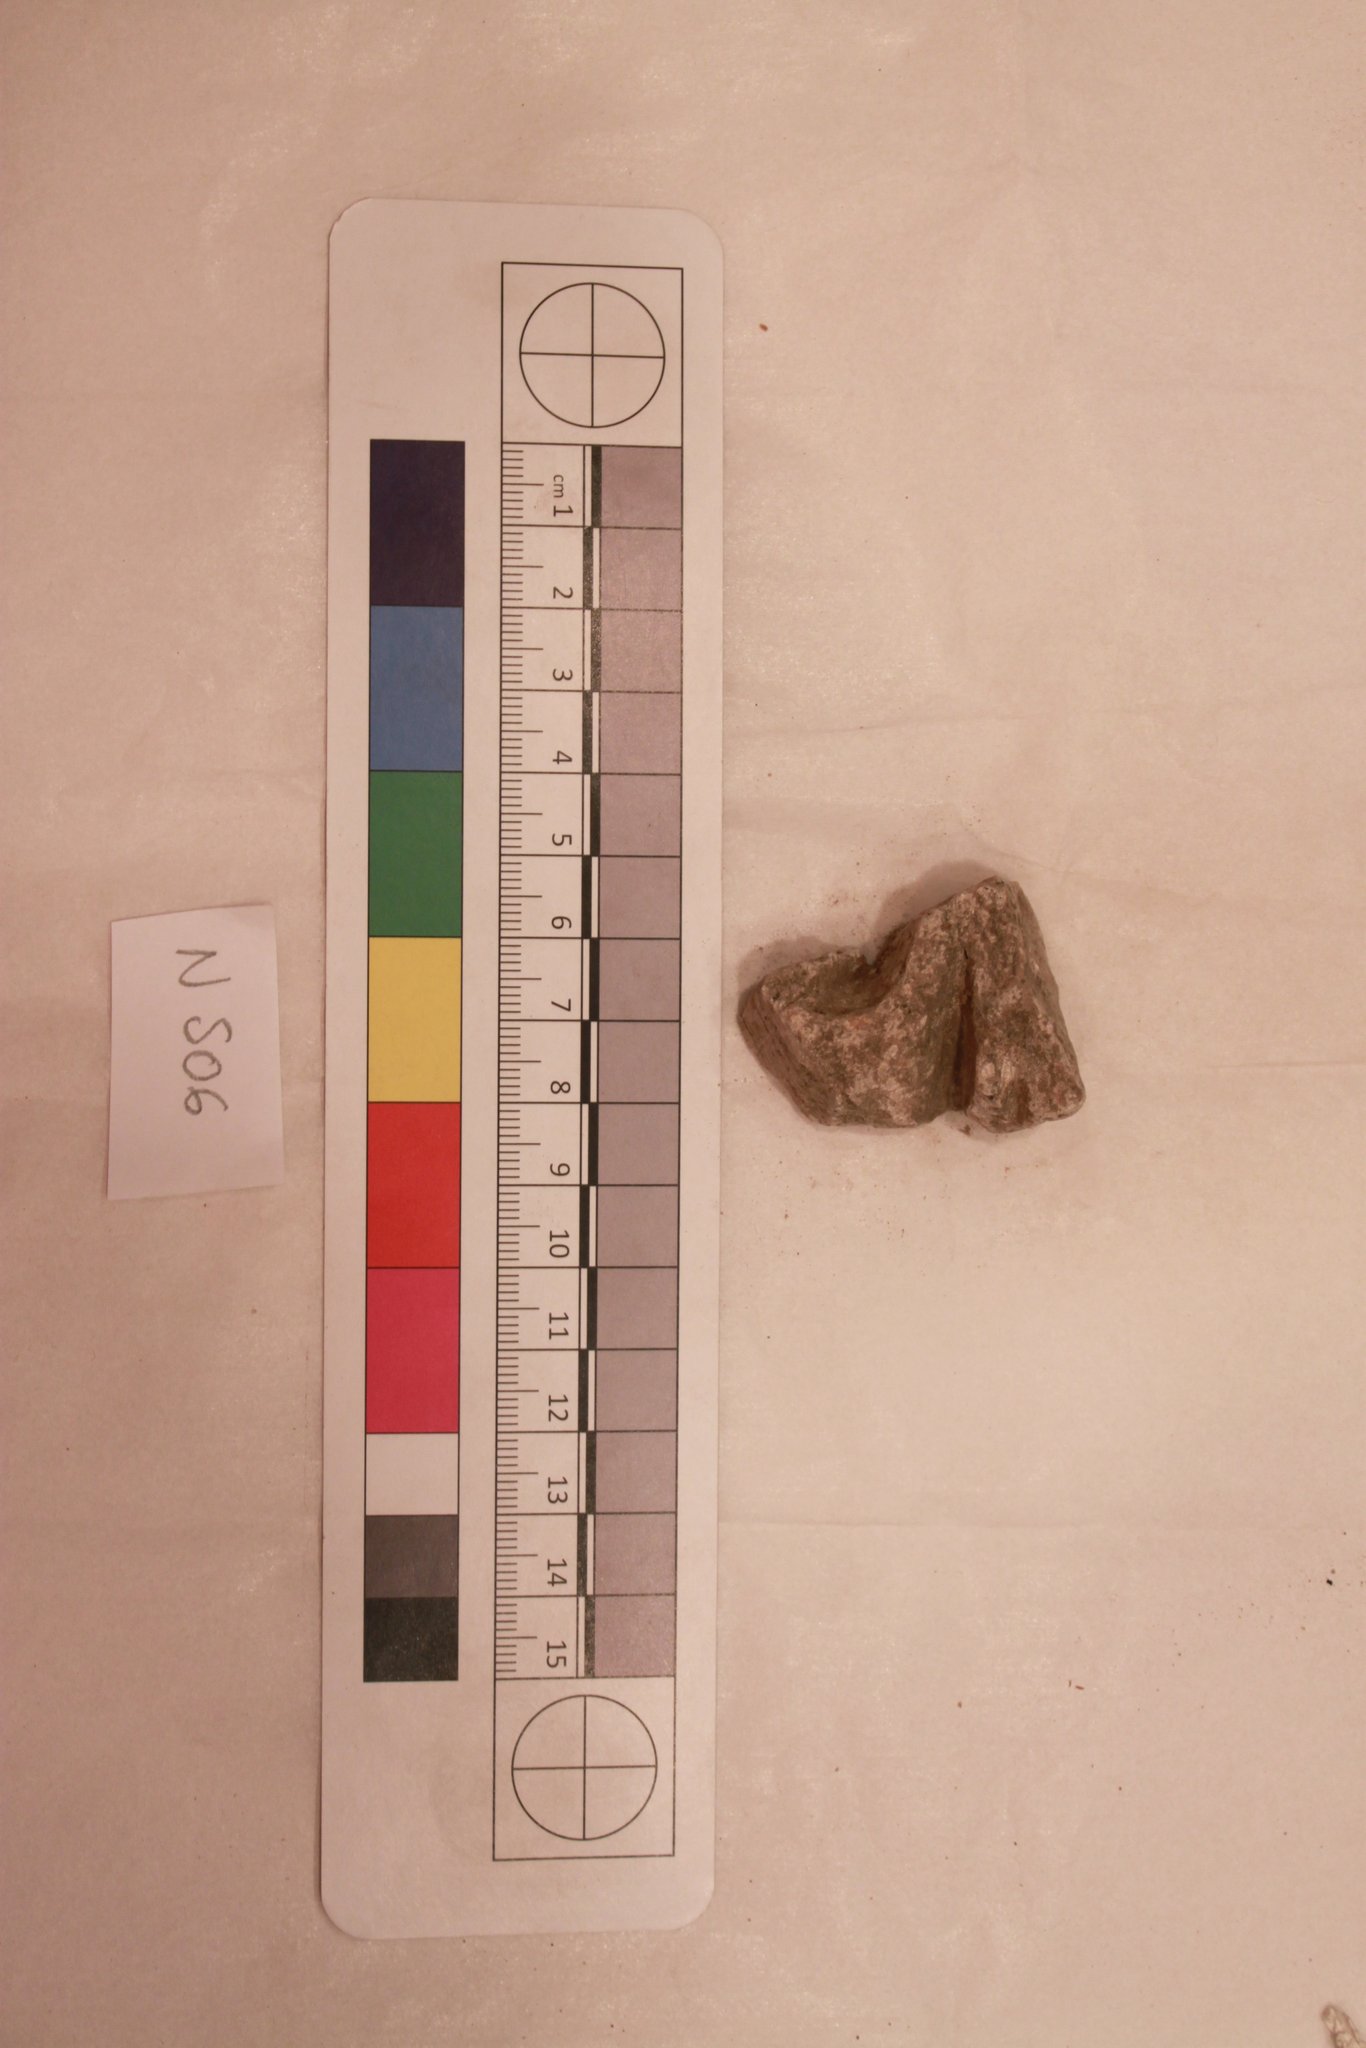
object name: fragment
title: Stucco Fragment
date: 701-1200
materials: plaster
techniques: carving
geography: iran